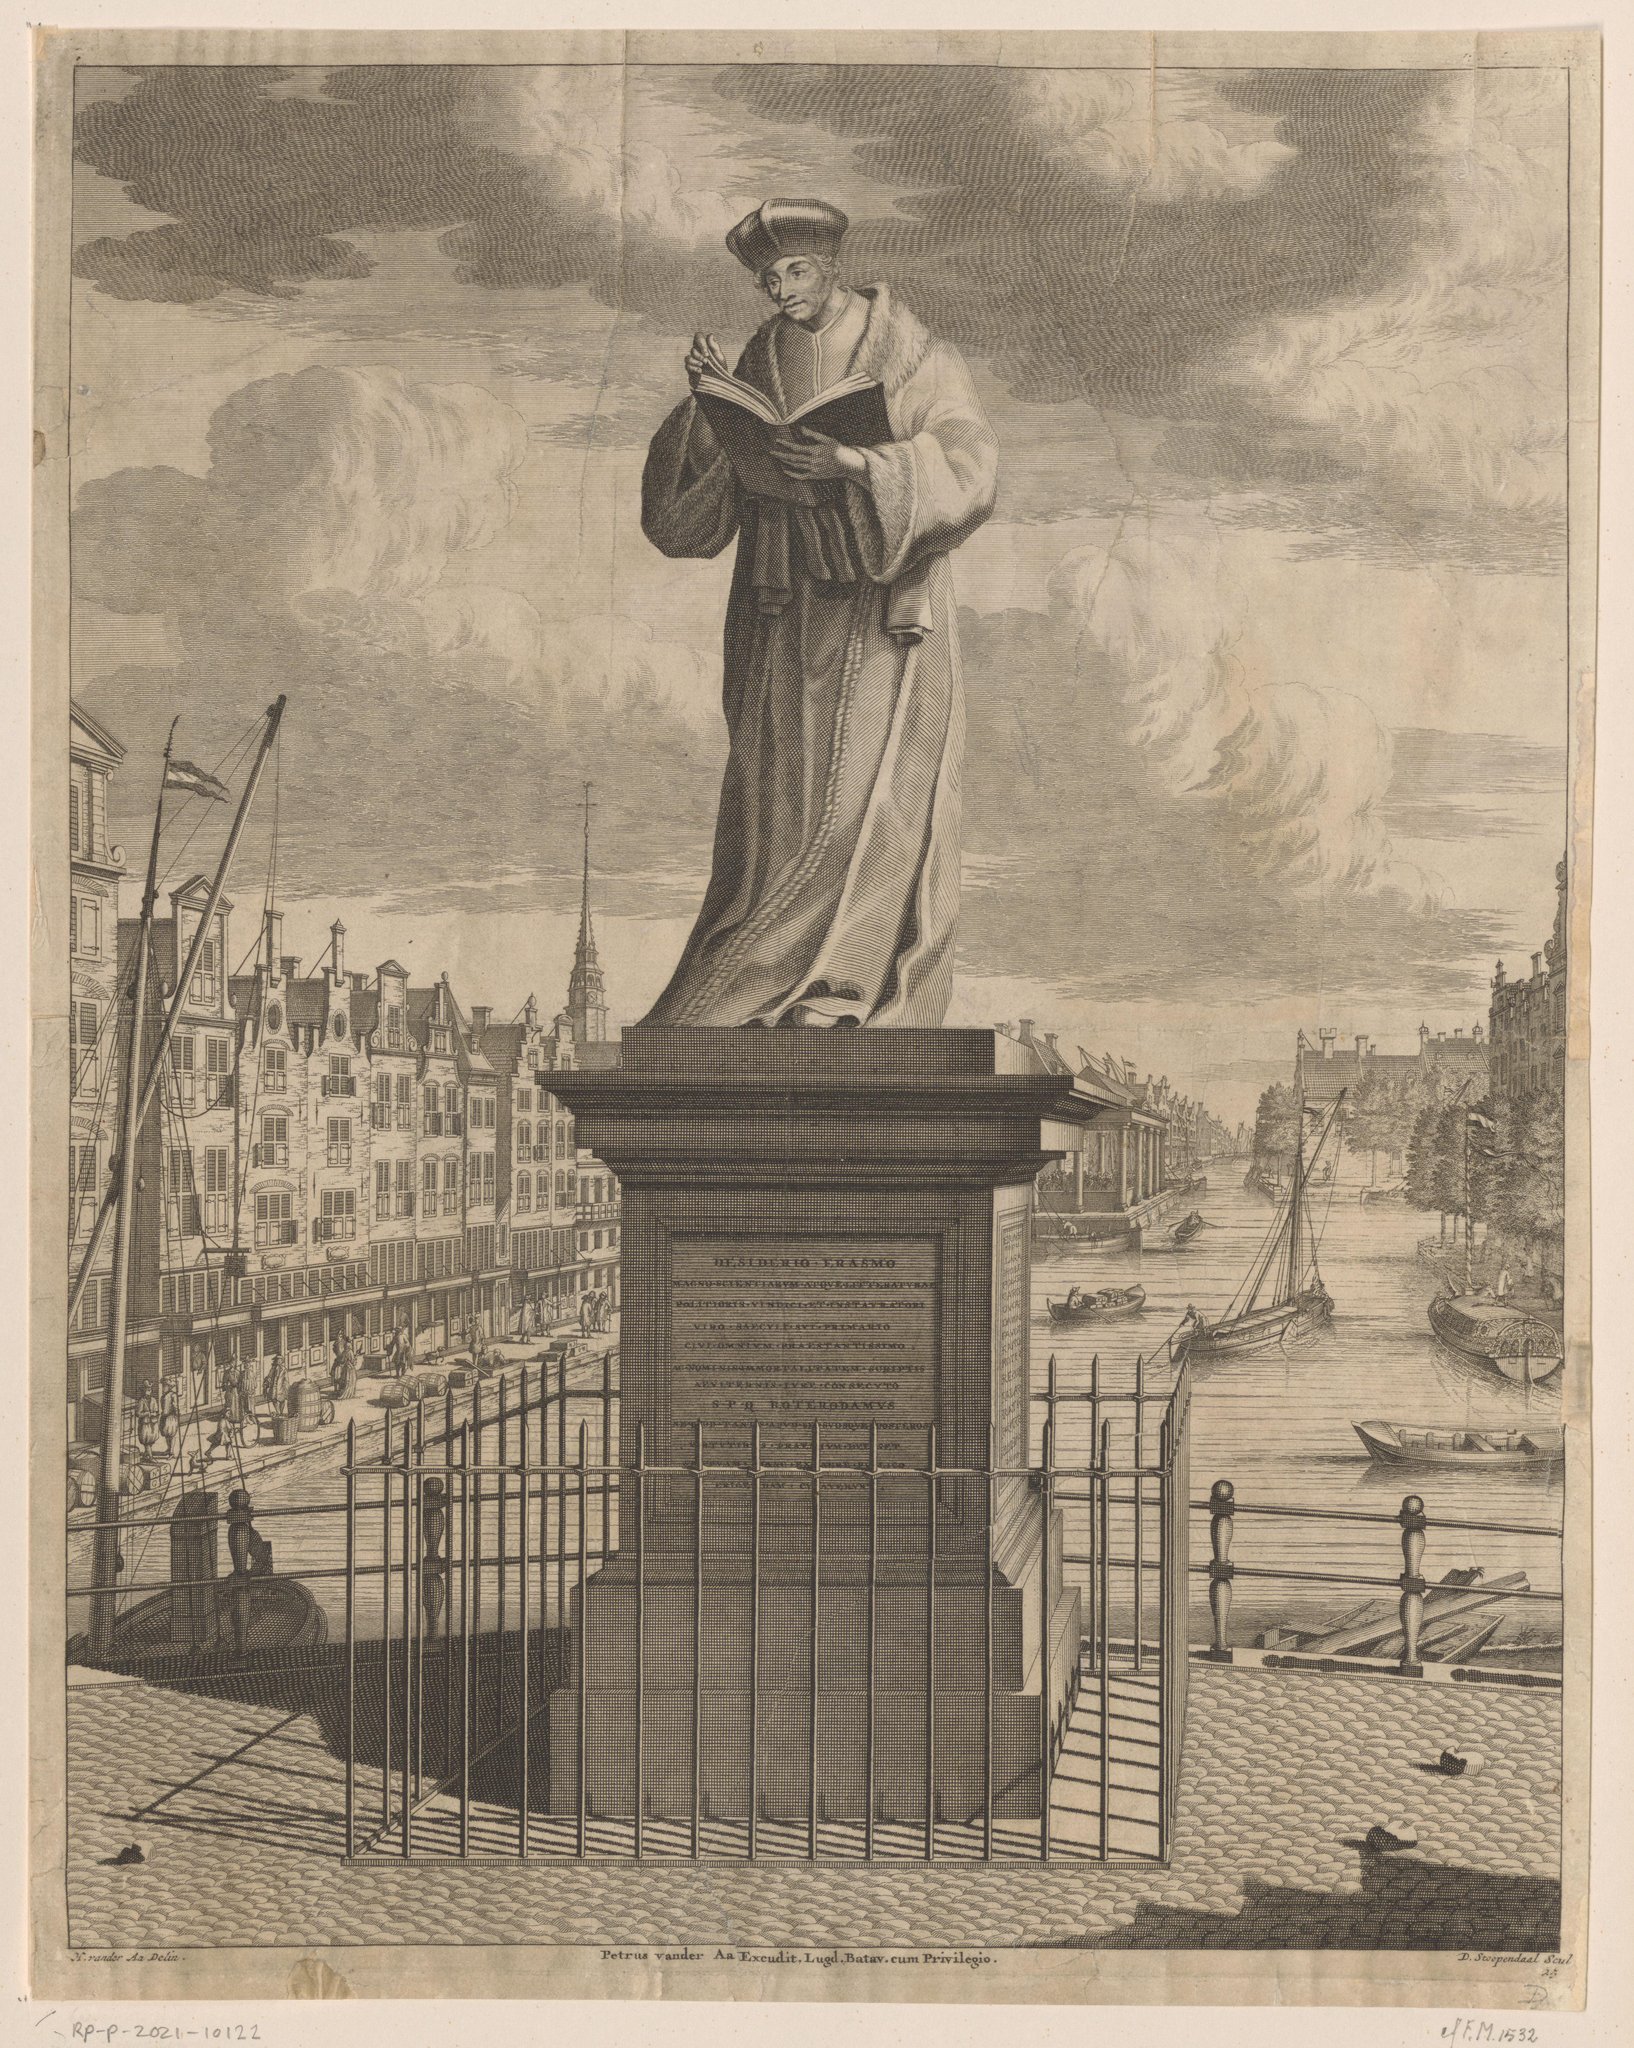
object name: print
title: Standbeeld van Desiderius Erasmus te Rotterdam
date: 1710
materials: paper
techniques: engraving, etching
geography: leiden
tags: rotterdam, desiderius erasmus, historical persons, monument, statue, canals, waters (in city) (+ city(-scape) with figures, staffage)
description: Eerste bekende staat van prent gebruikt in: Clerc, Jean le ed. Desiderii Erasmi Roterodami Opera Omnia emendatiora et auctiora, ad optimas editiones (…). 10 dln. Leiden: Pieter van der Aa (I), 1703, dl. 1. De eerste bekende staat is rechtsboven gemerkt: Pag (6) in Passat. Deze tweede bekende staat is rechtsonder genummerd: 25. Op de derde bekende staat (RP-P-1906-1558) is zowel de markering rechtsboven als het nummer rechtsonder zichtbaar uitgewist.